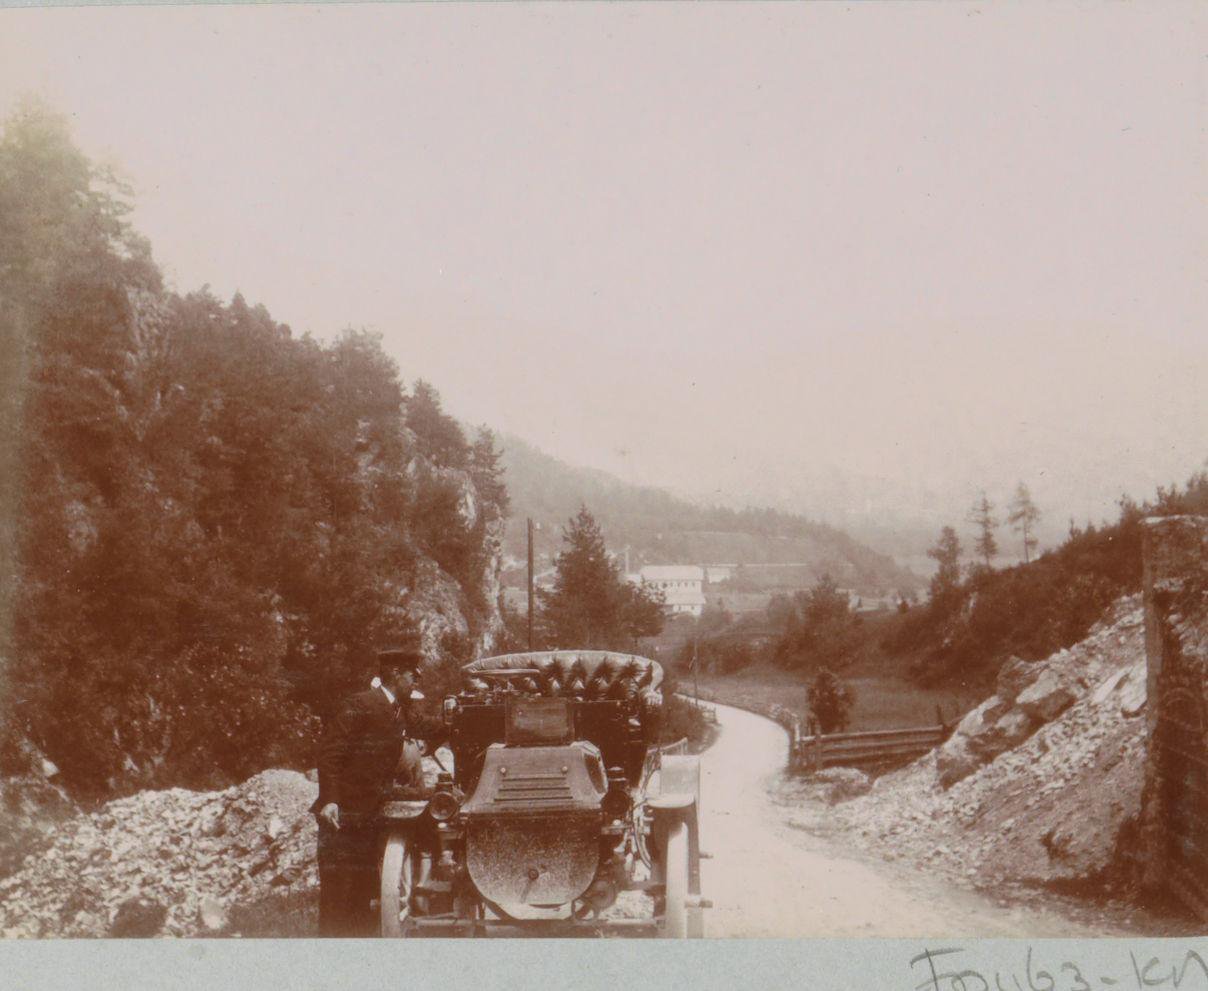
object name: photograph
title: Man bij een automobiel, vermoedelijk in de buurt van de Inn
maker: delizy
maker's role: manufacturer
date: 1900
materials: paper, photographic support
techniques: gelatin silver print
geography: innsbruck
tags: maintenance, repair, storage ~ motor vehicles, automobile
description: Onderdeel van Fotoalbum van een Franse amateurfotograaf met opnames van uitstapjes in Frankrijk, Spanje, België, Luxemburg en Nederland, de eerste automobielen en autoraces.